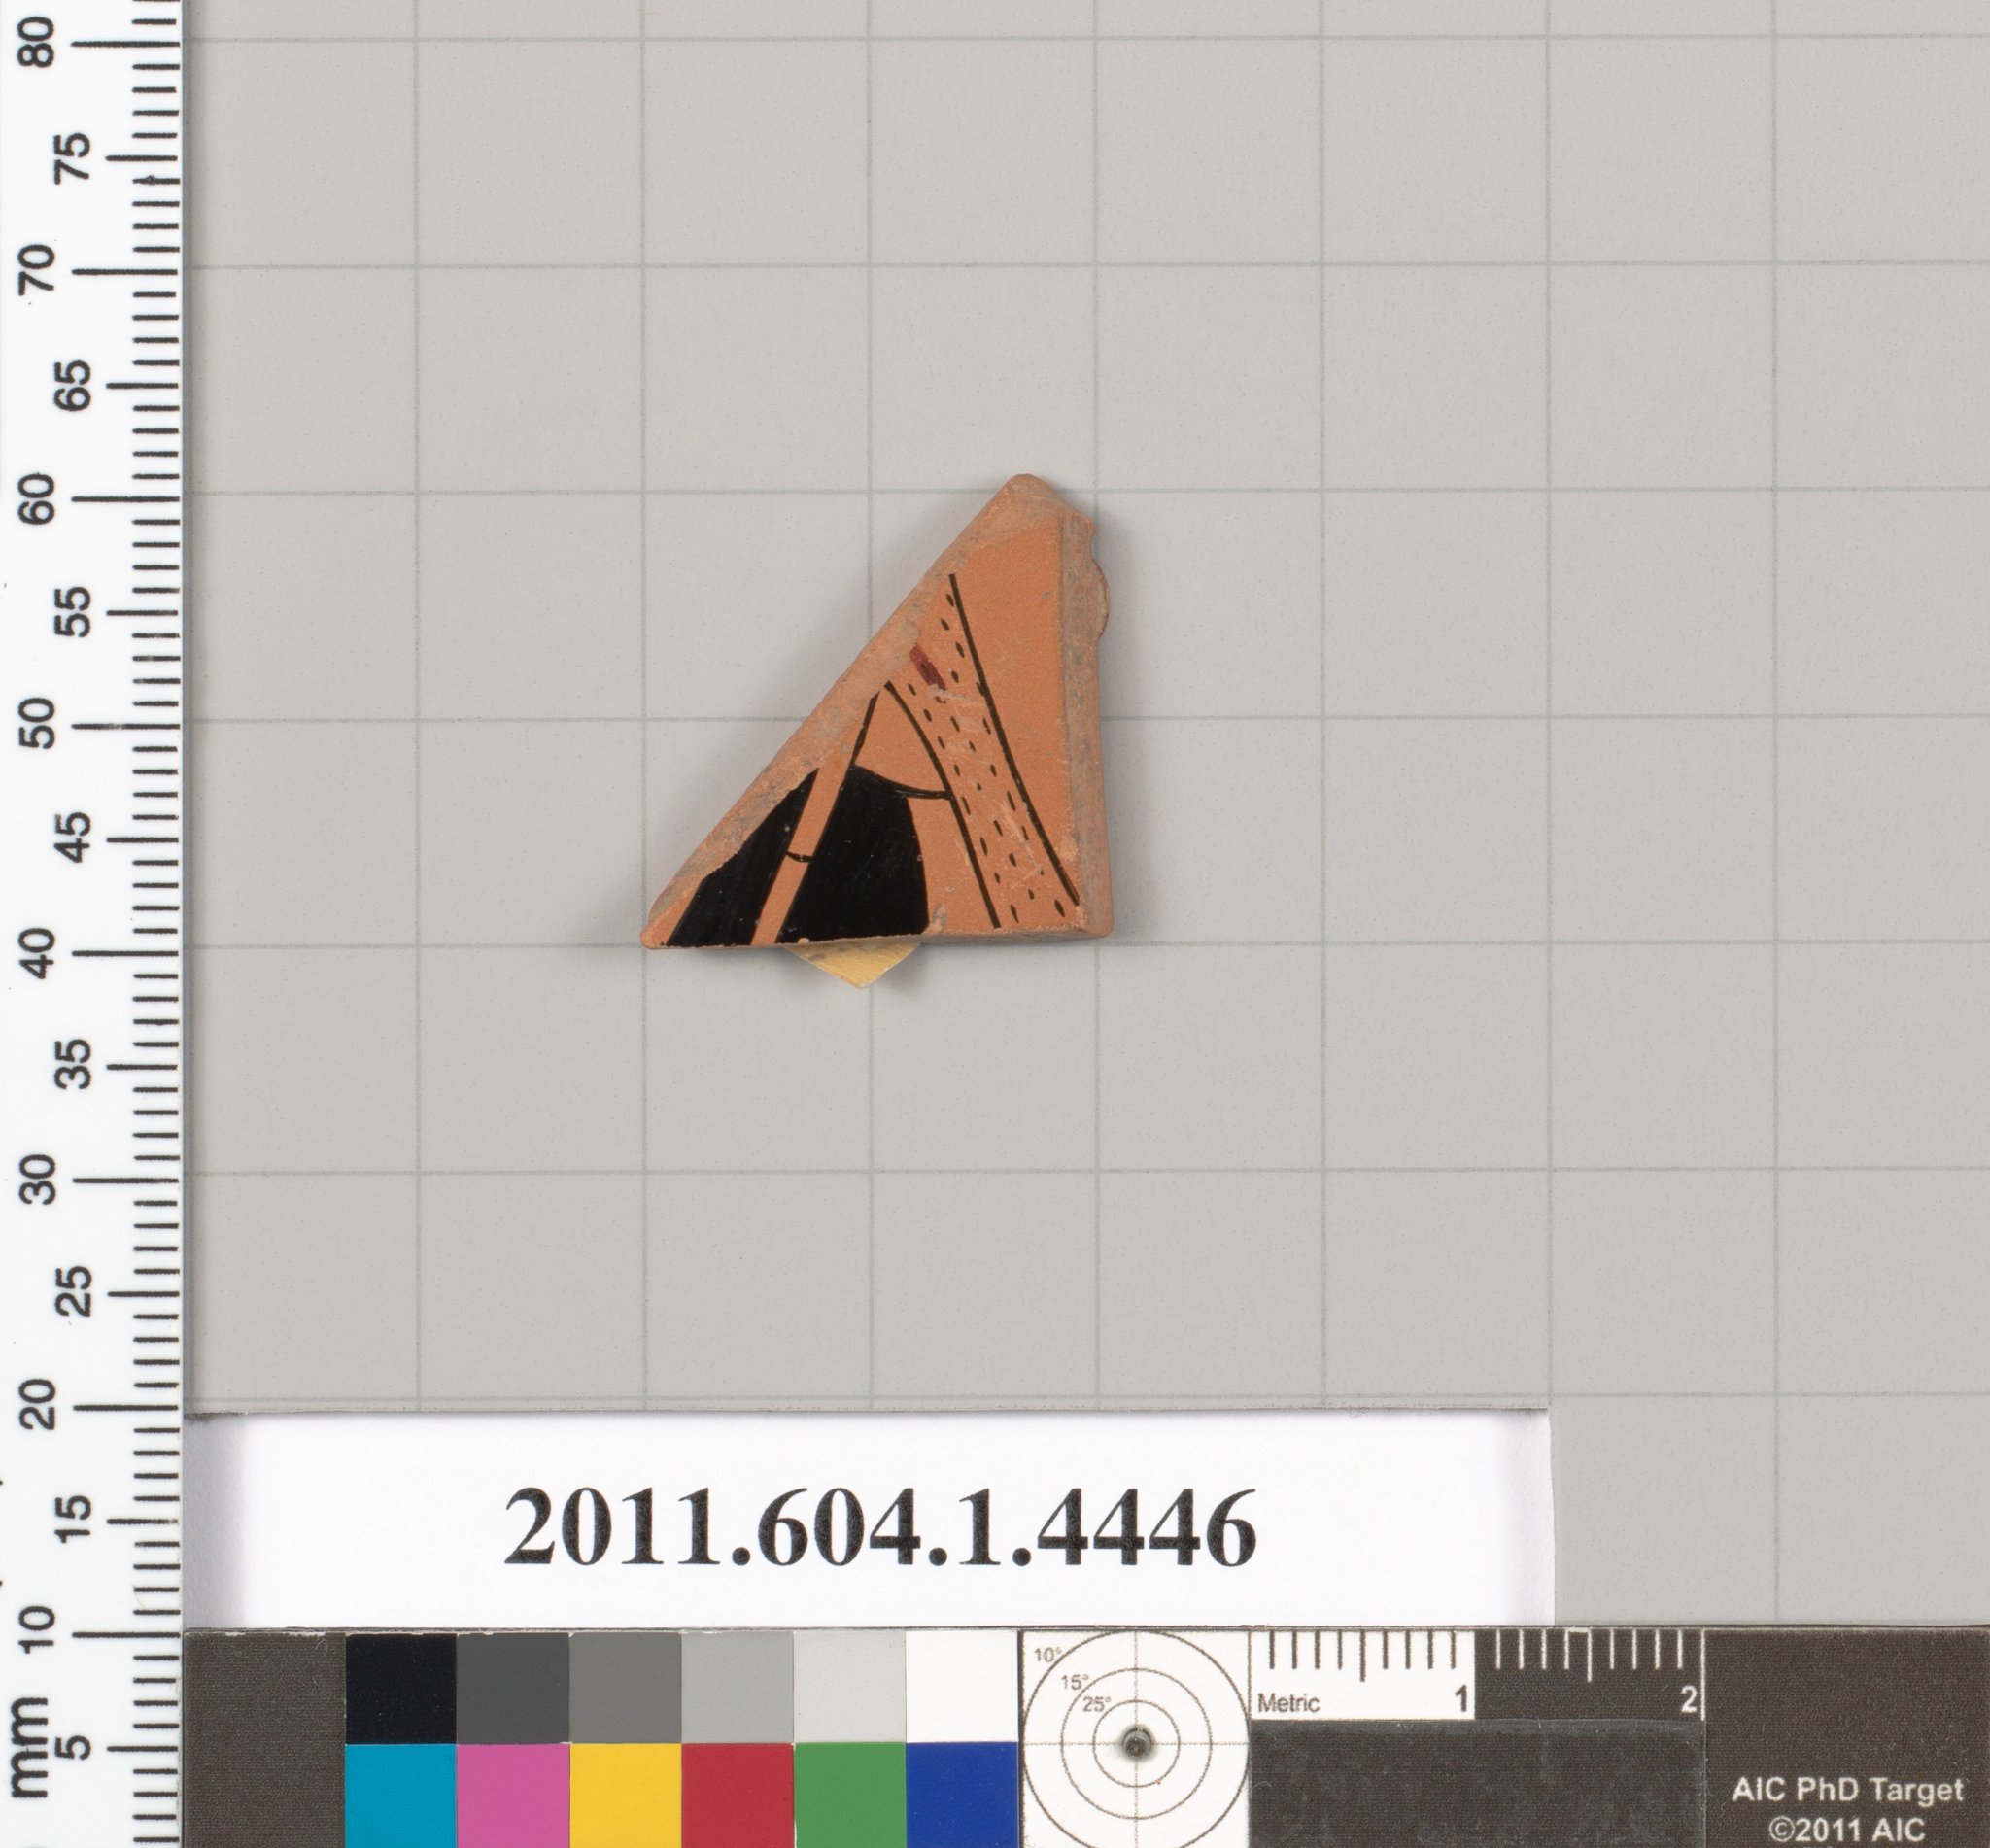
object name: kylix fragment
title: Terracotta fragment of a kylix (drinking cup)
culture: greek, attic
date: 490-470 BCE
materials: terracotta